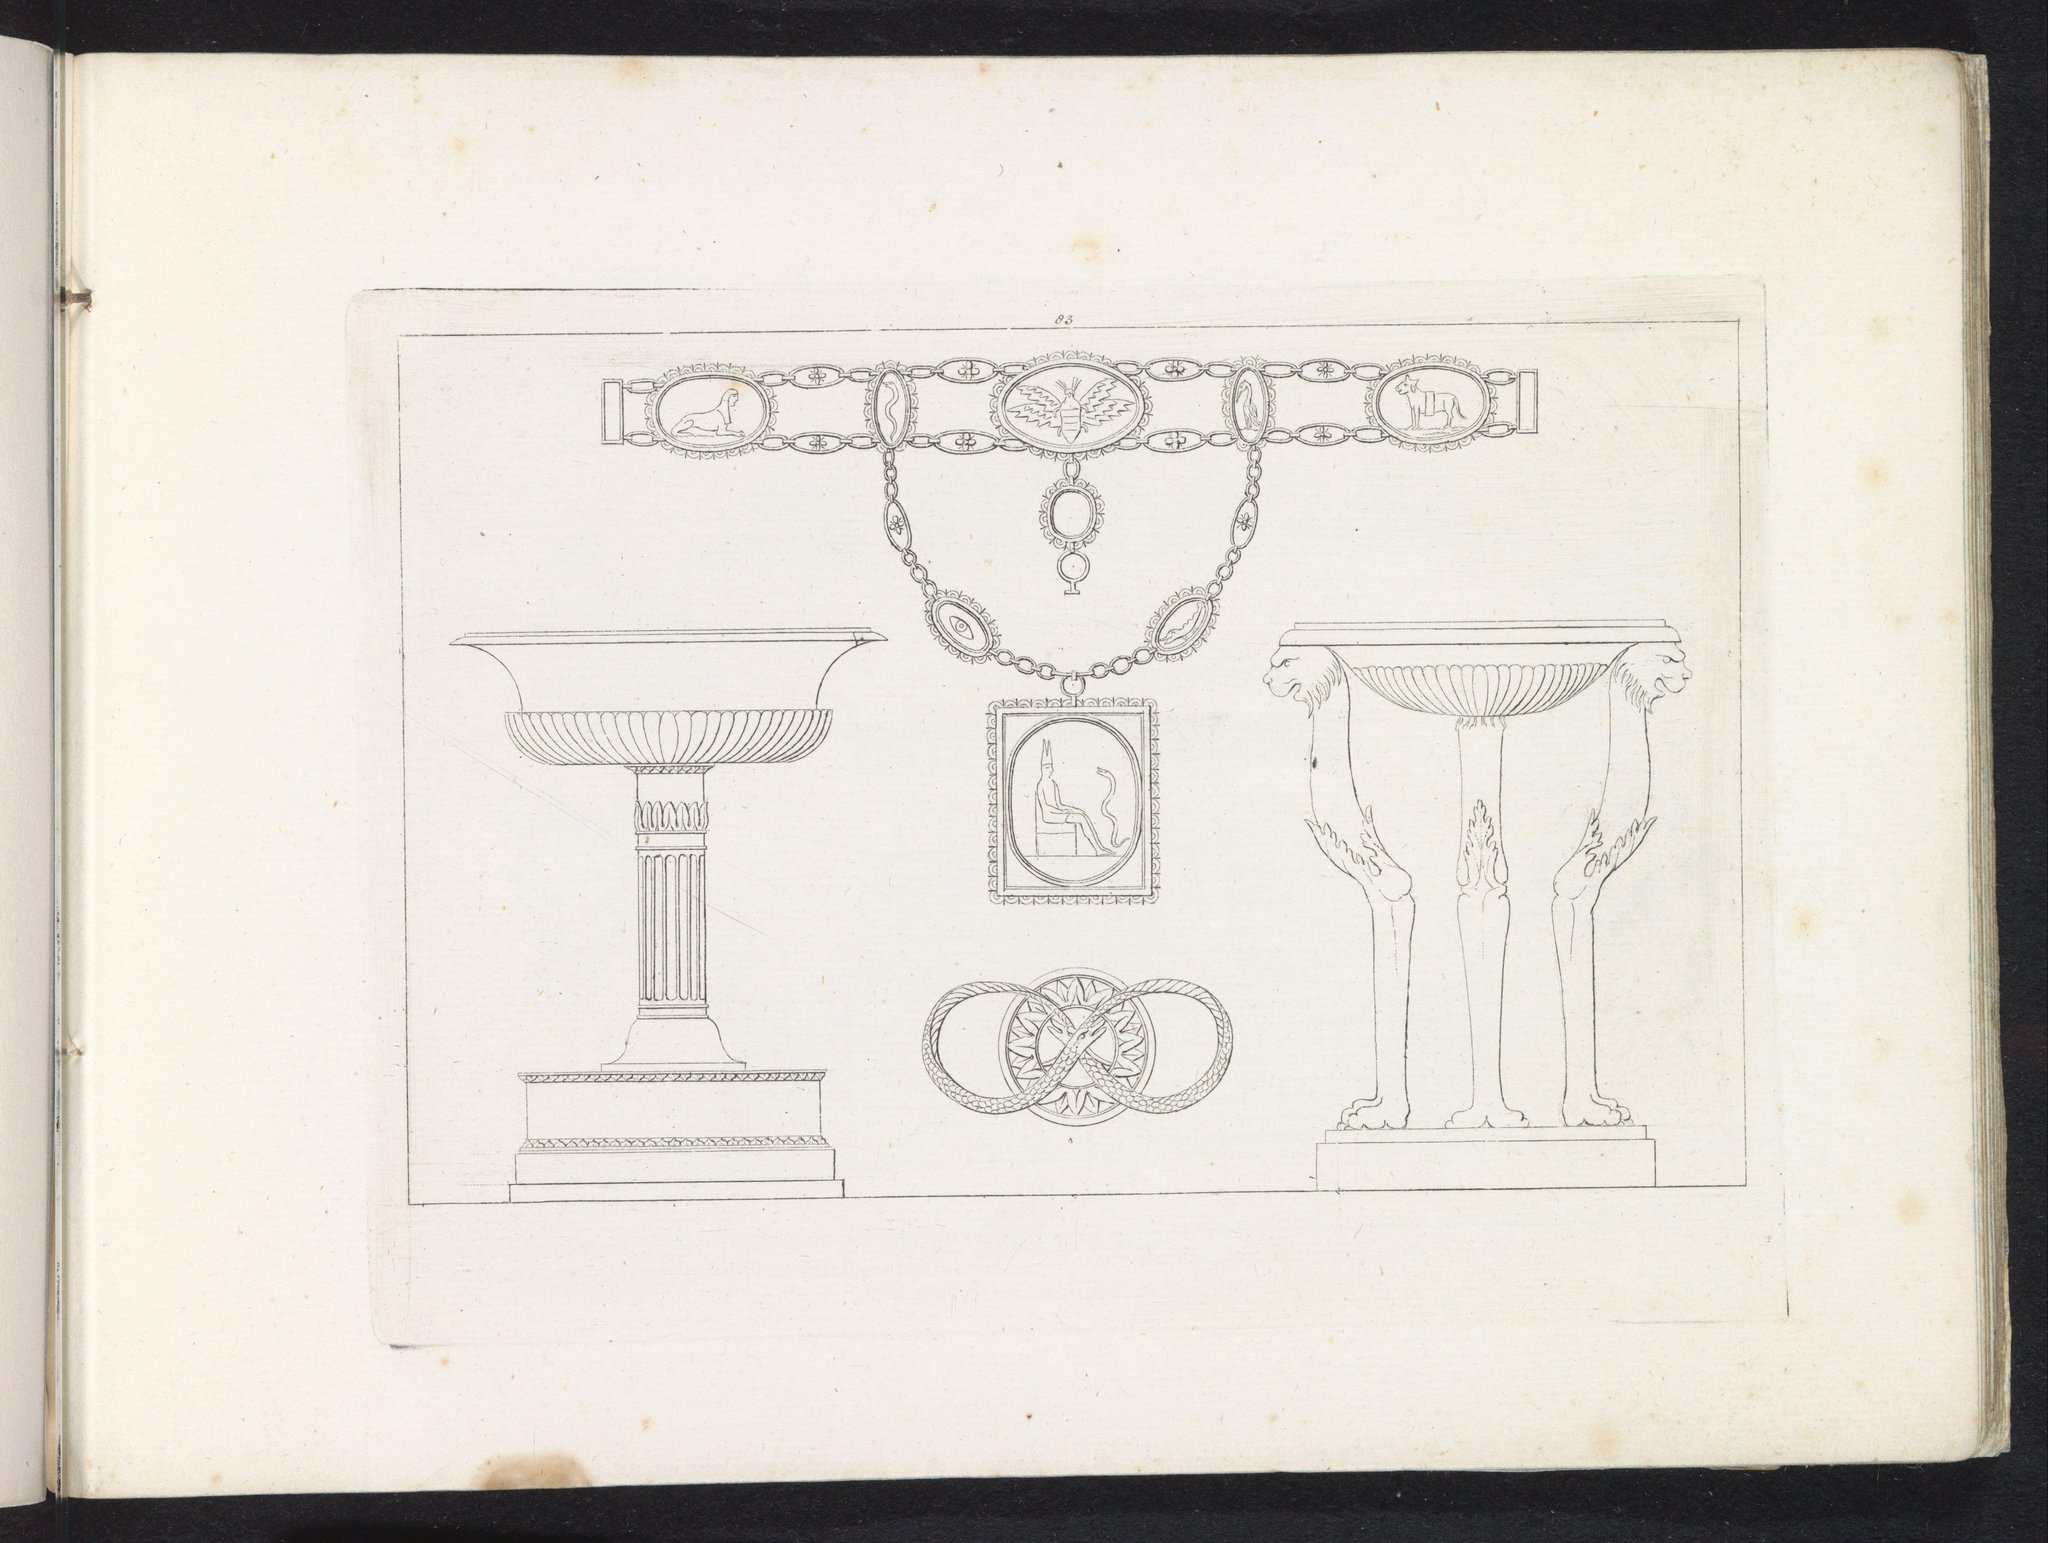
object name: album leaf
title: Ontwerpen voor religieuze en profane voorwerpen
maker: pietro ruga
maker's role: print maker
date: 1817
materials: paper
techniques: etching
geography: italy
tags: ornaments ~ art, table, serpent ouroboros, baptismal font, necklace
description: Prent maakt deel uit van een reeks van 100 prenten (+ titelprent) met ontwerpen voor religieuze en profane voorwerpen.